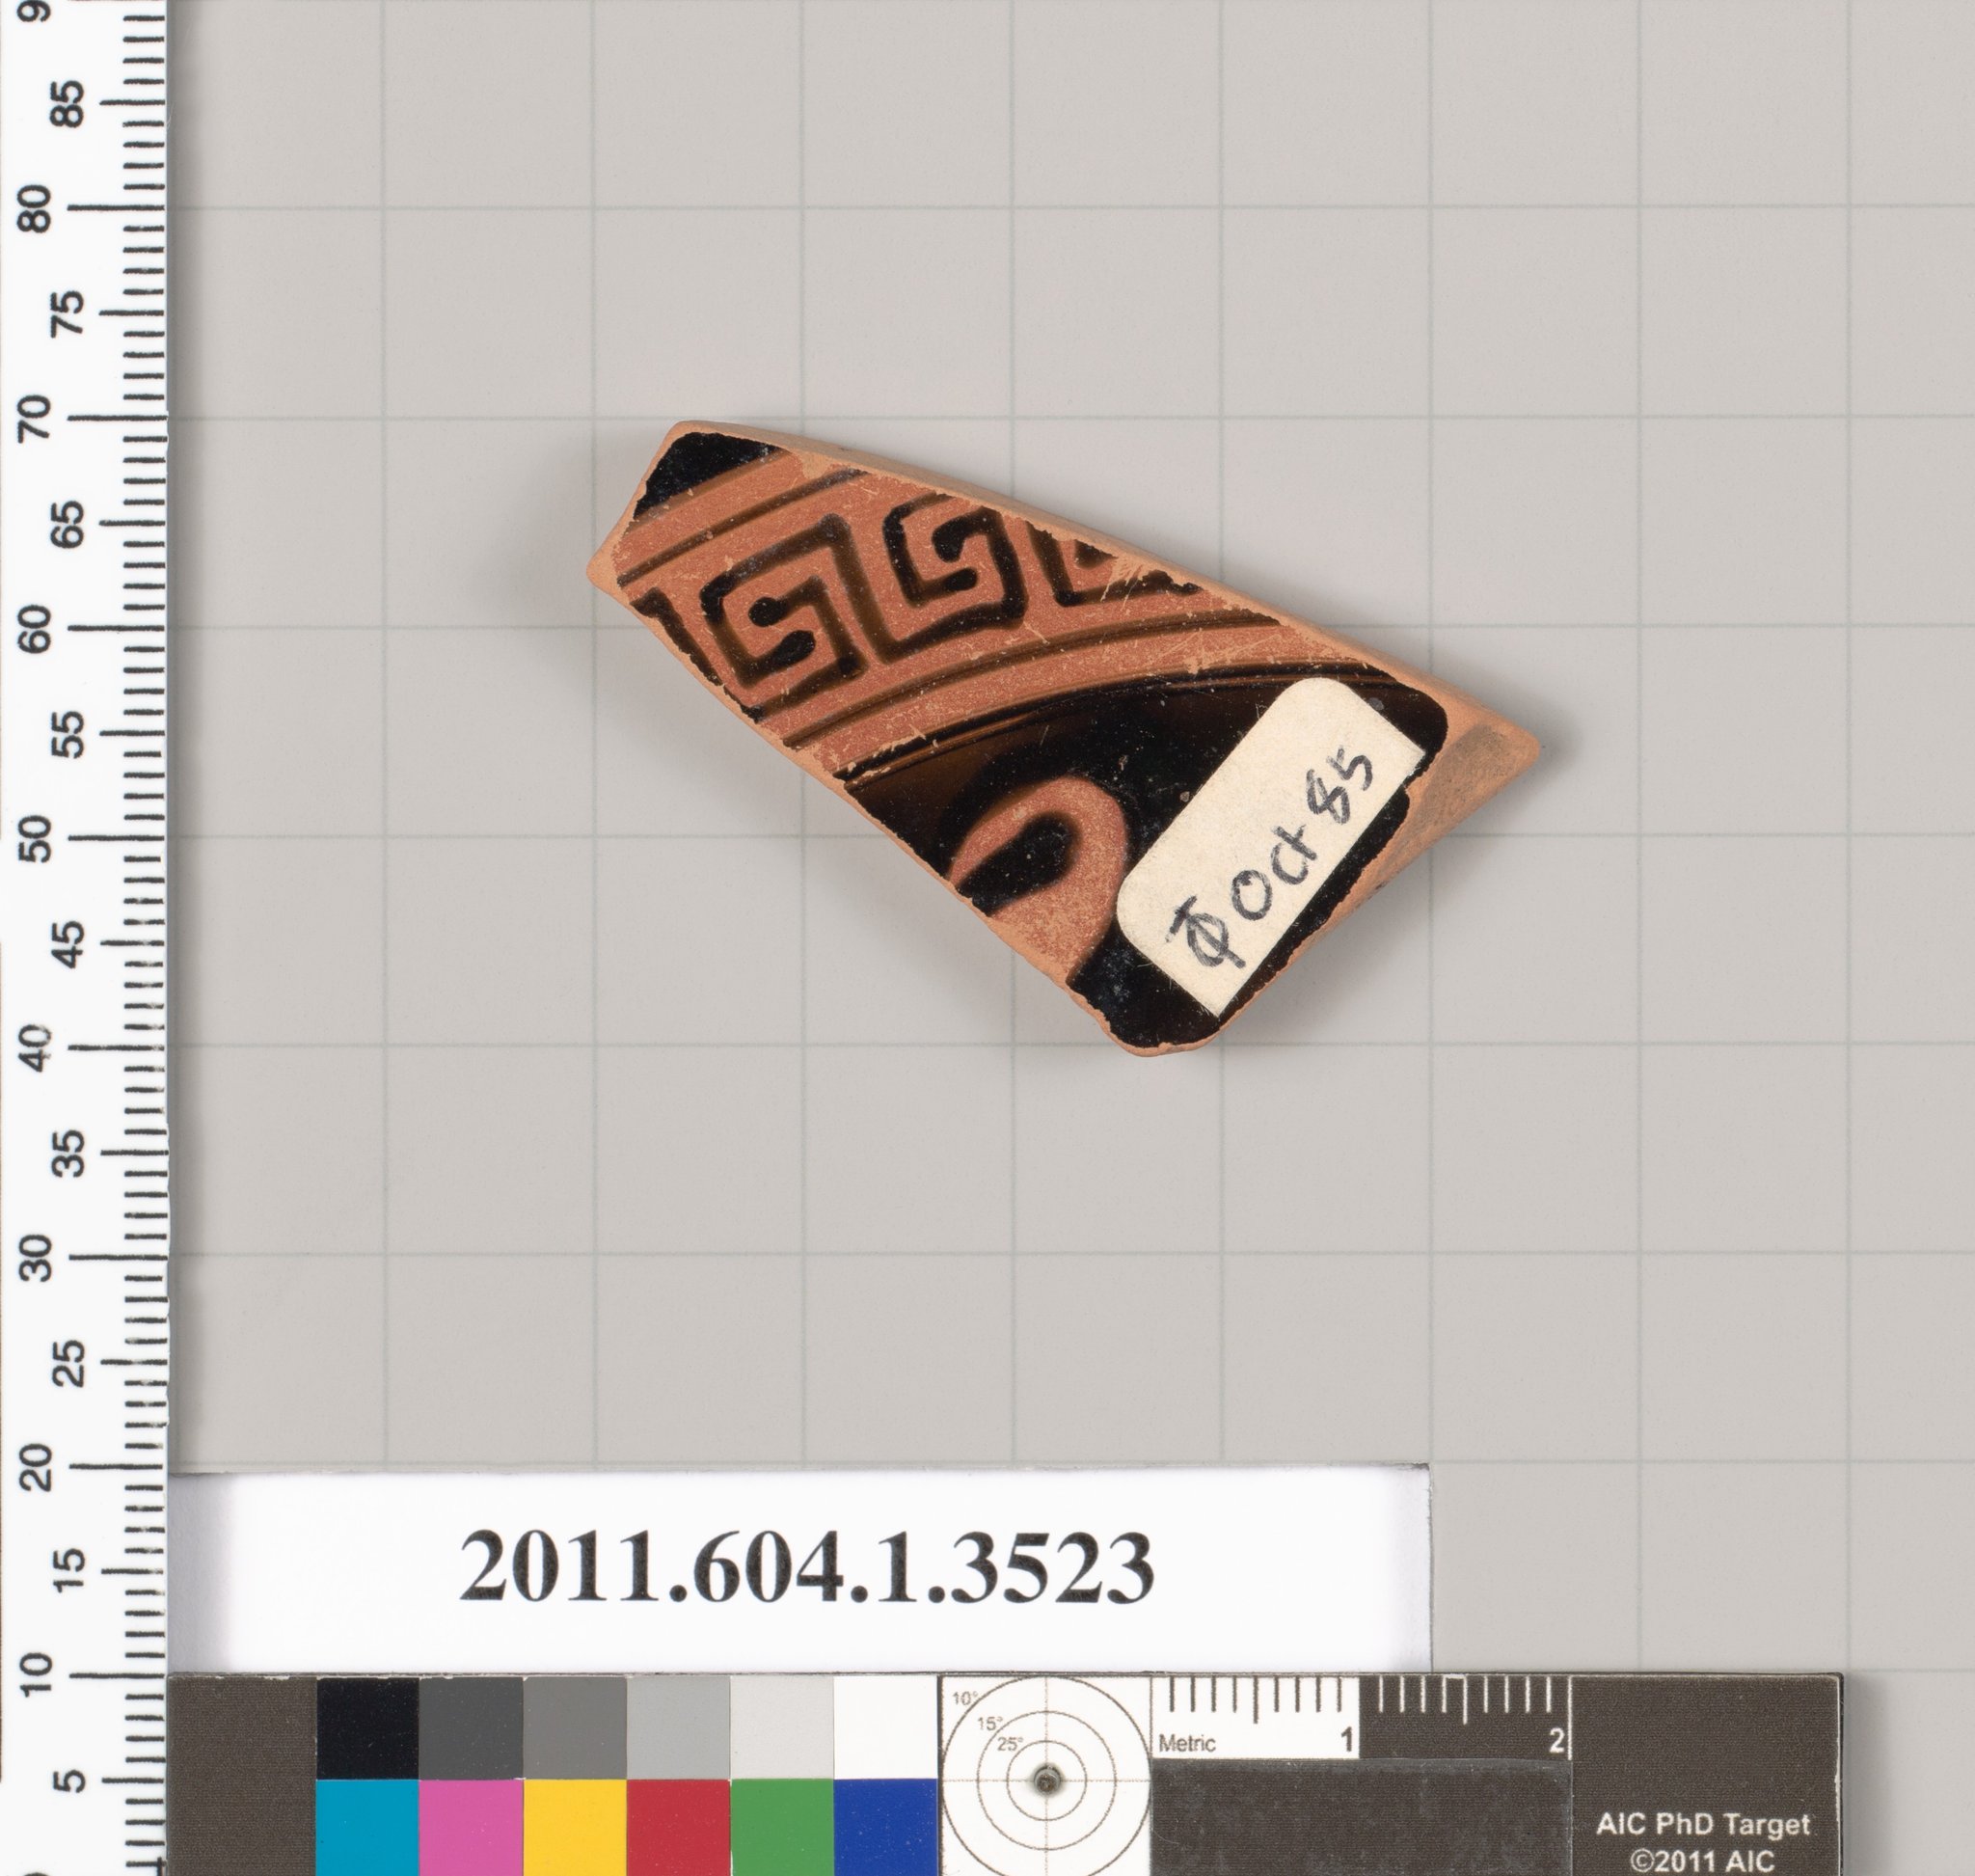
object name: kylix fragment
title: Terracotta fragment of a kylix (drinking cup)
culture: greek, attic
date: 475-451 BCE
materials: terracotta